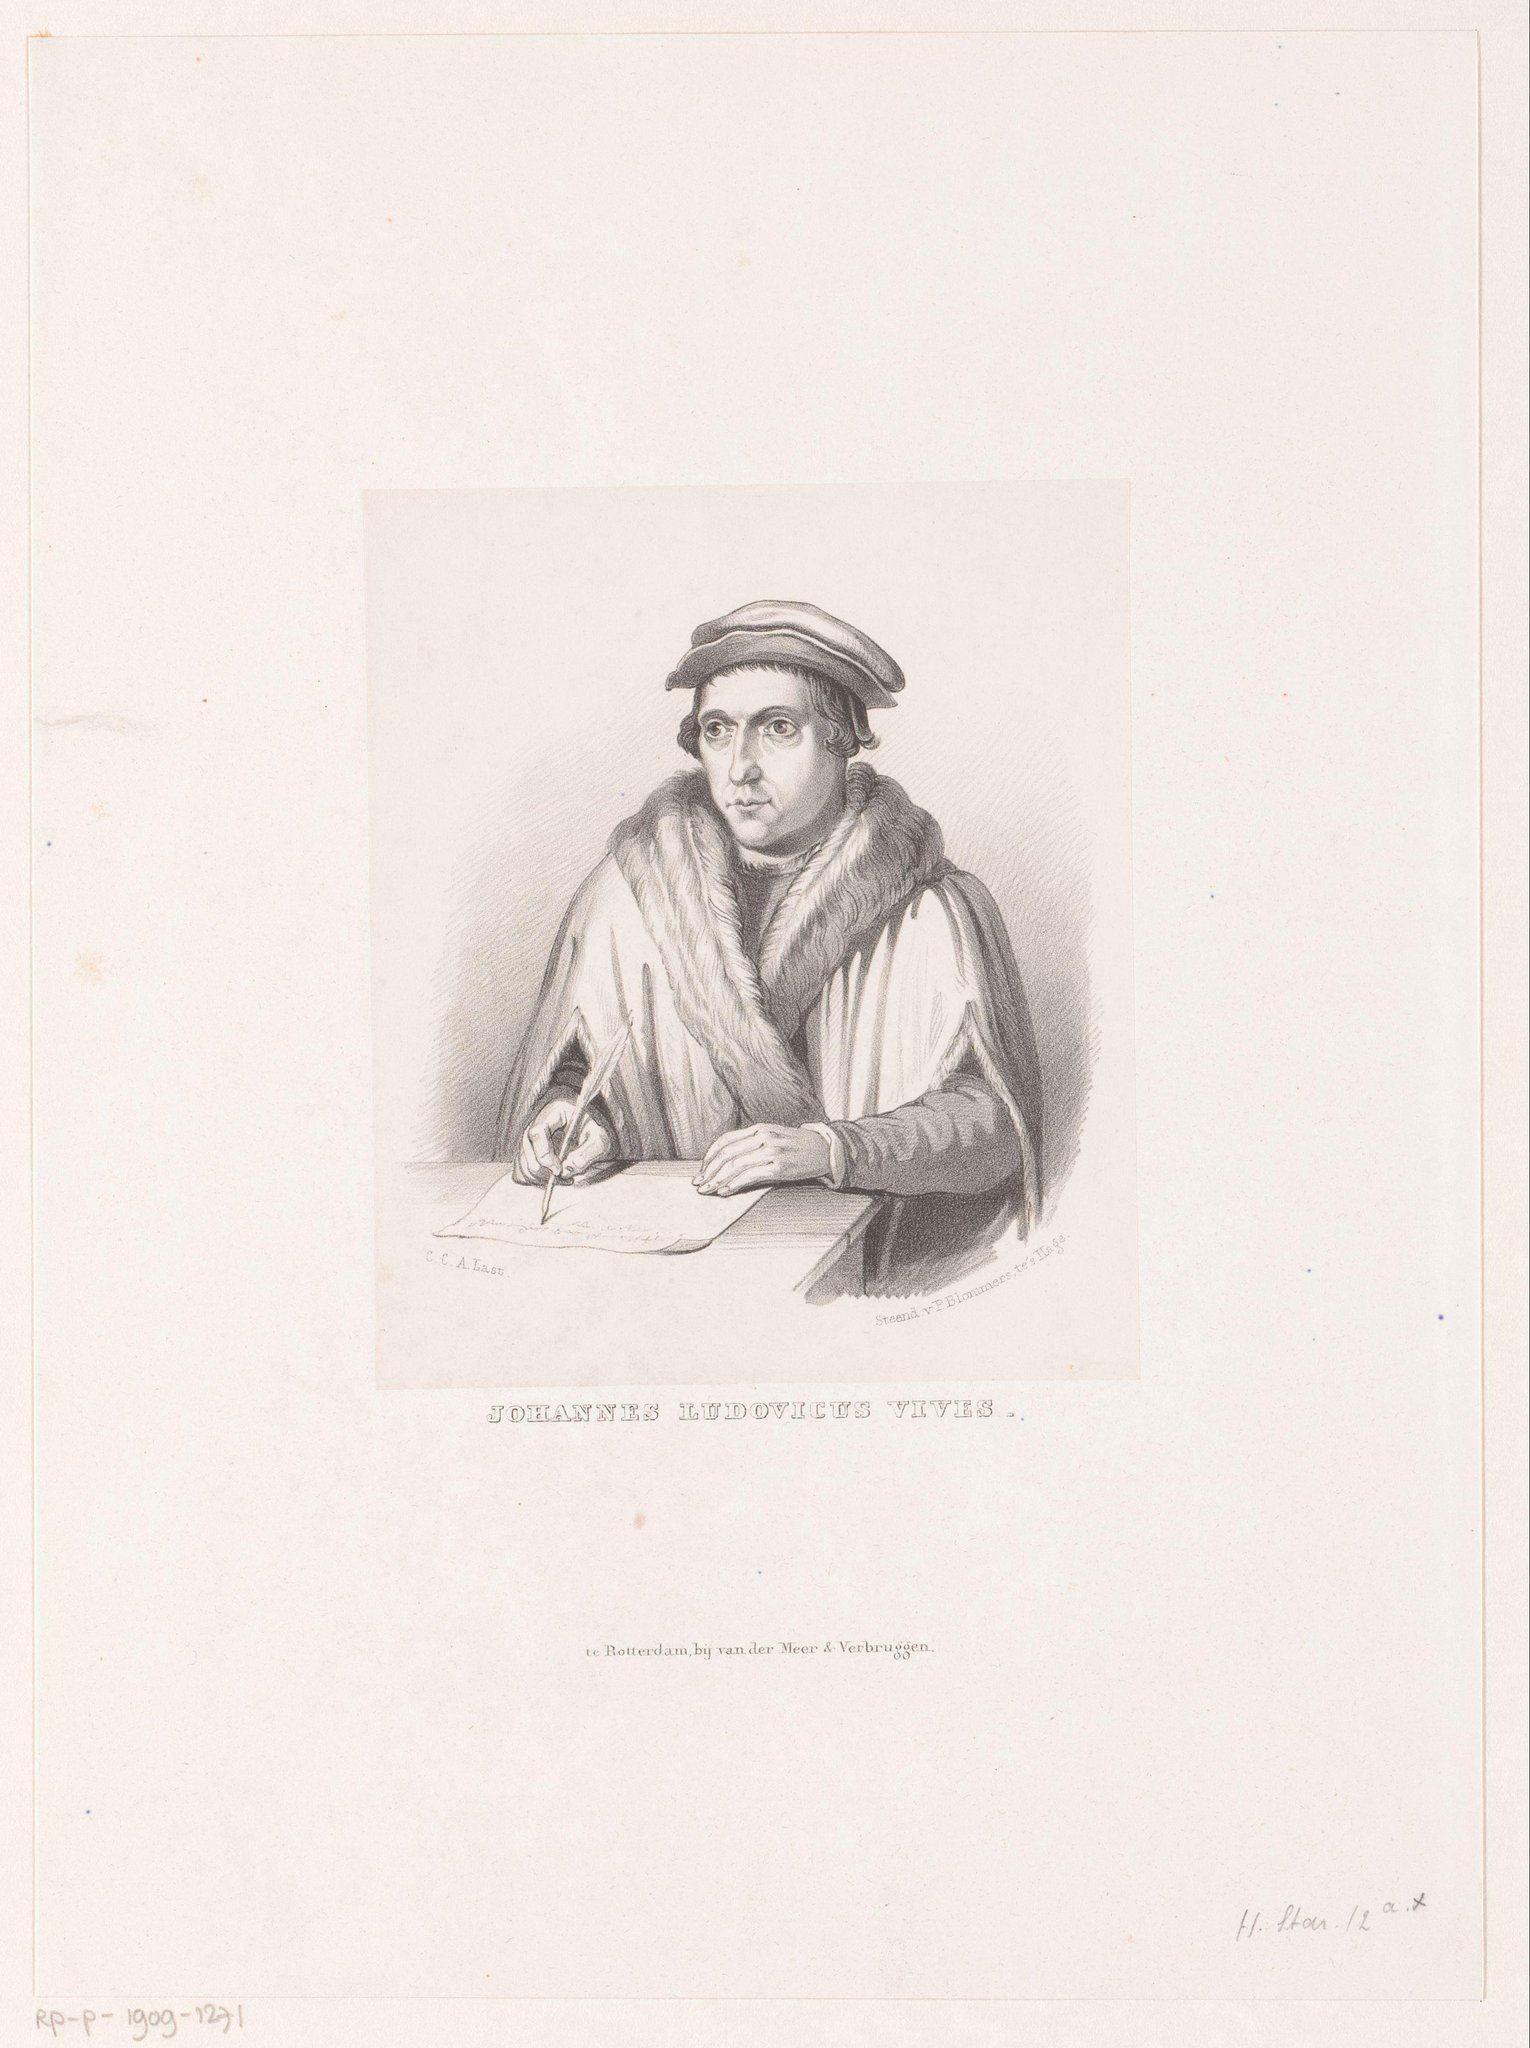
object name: print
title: Portret van Juan Luis Vives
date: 1842-1860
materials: paper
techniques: lithograph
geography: the hague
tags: quill (+ scholar, scientist (at work)), historical persons (+ (full) bust portrait)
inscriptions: collector's mark: Lugt 2228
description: De geportretteerde zit aan een tafel en schrijft met een veer op een vel papier.